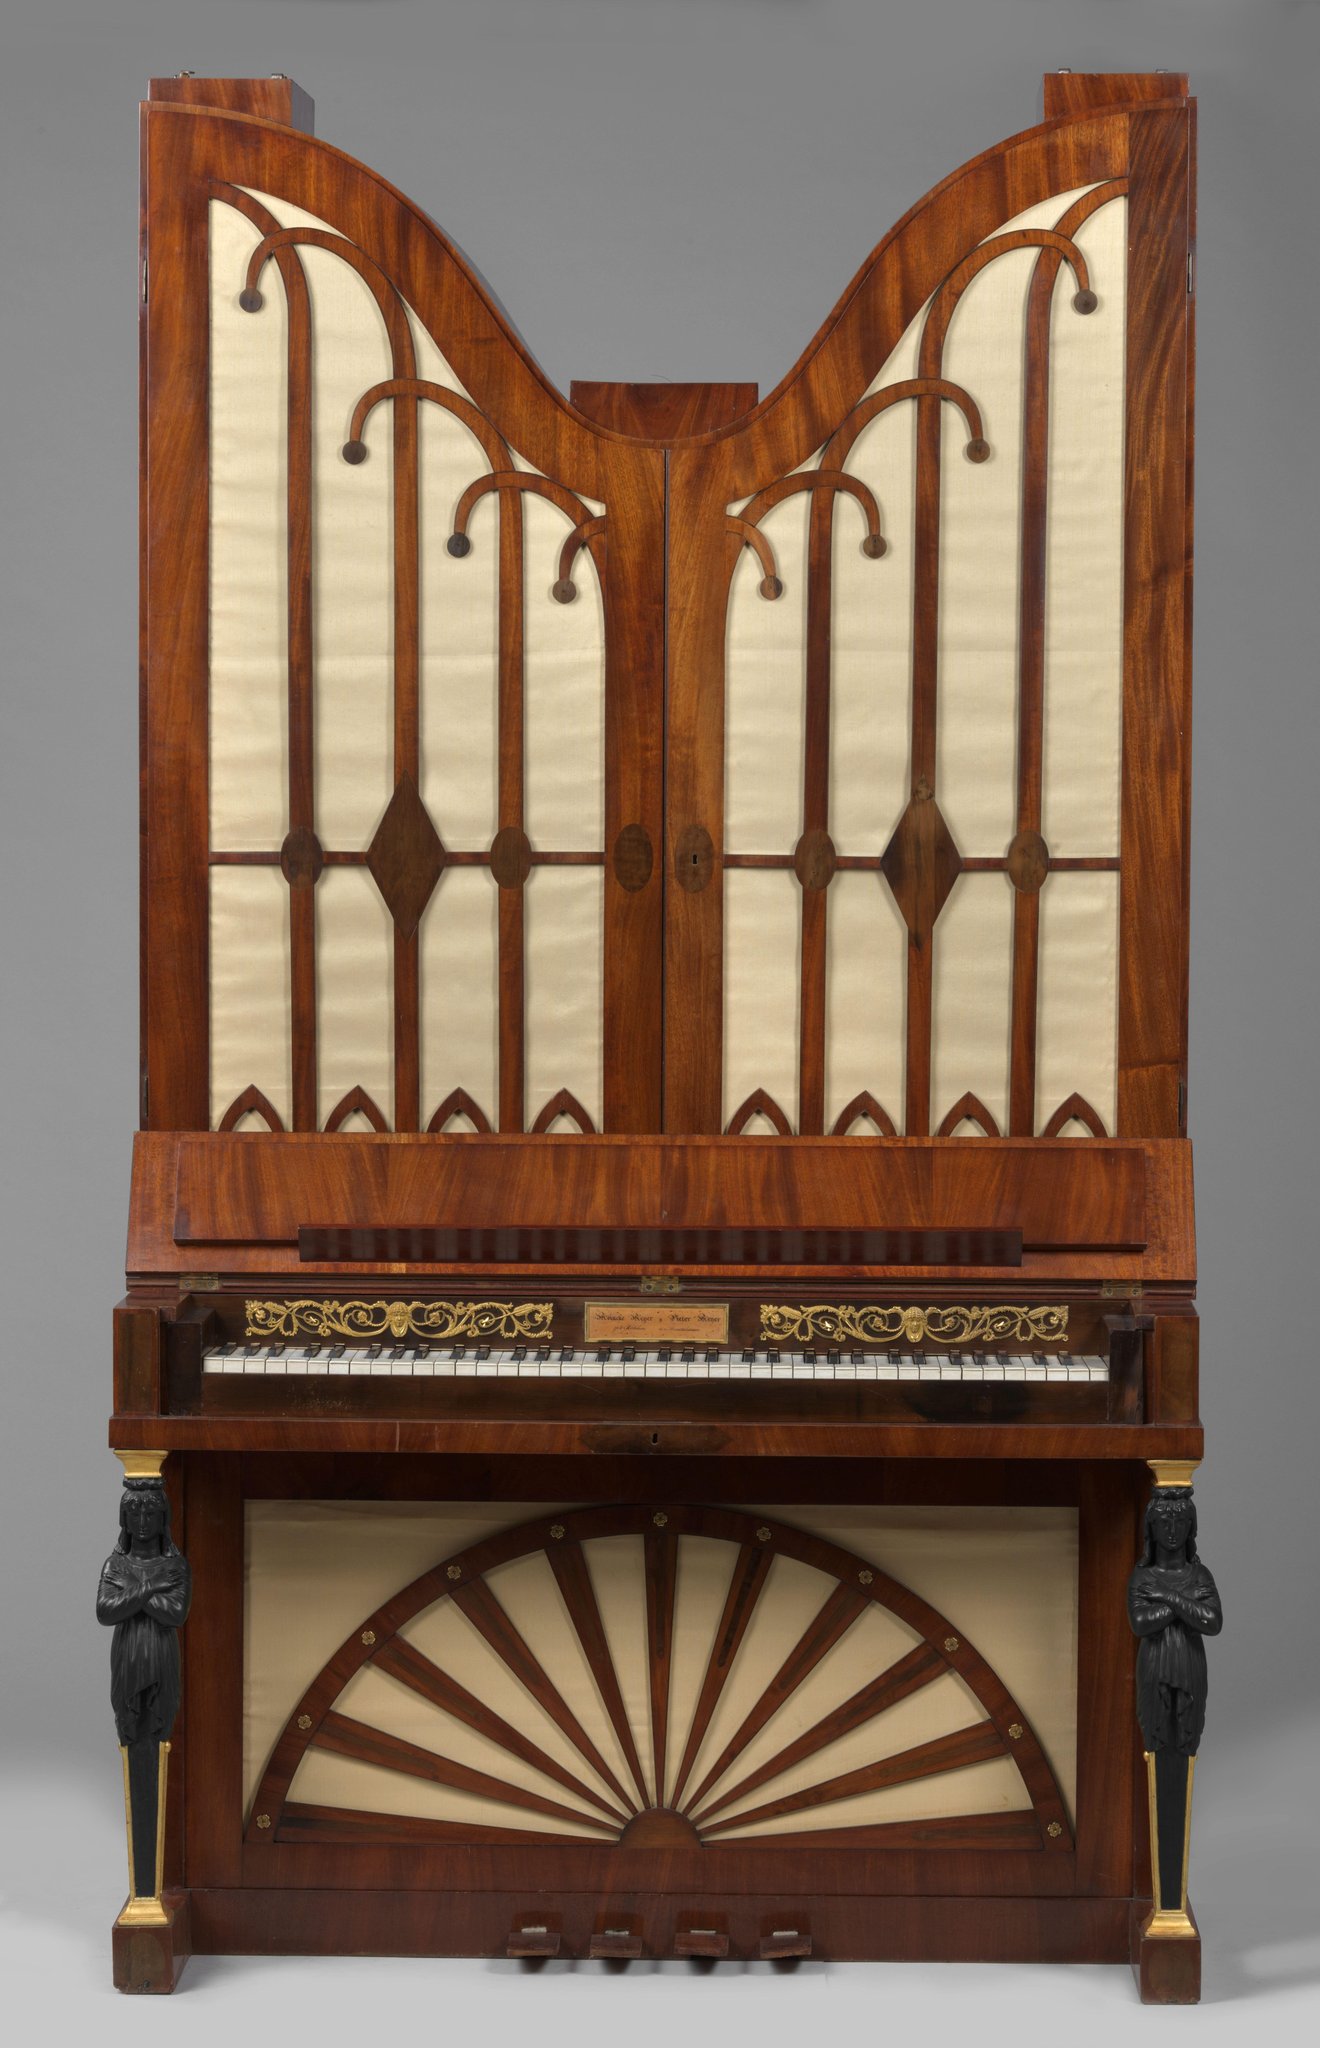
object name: cabinet piano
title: Cabinet piano (Apollo piano)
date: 1815-1820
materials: brass, wood, iron, ivory, textile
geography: amsterdam